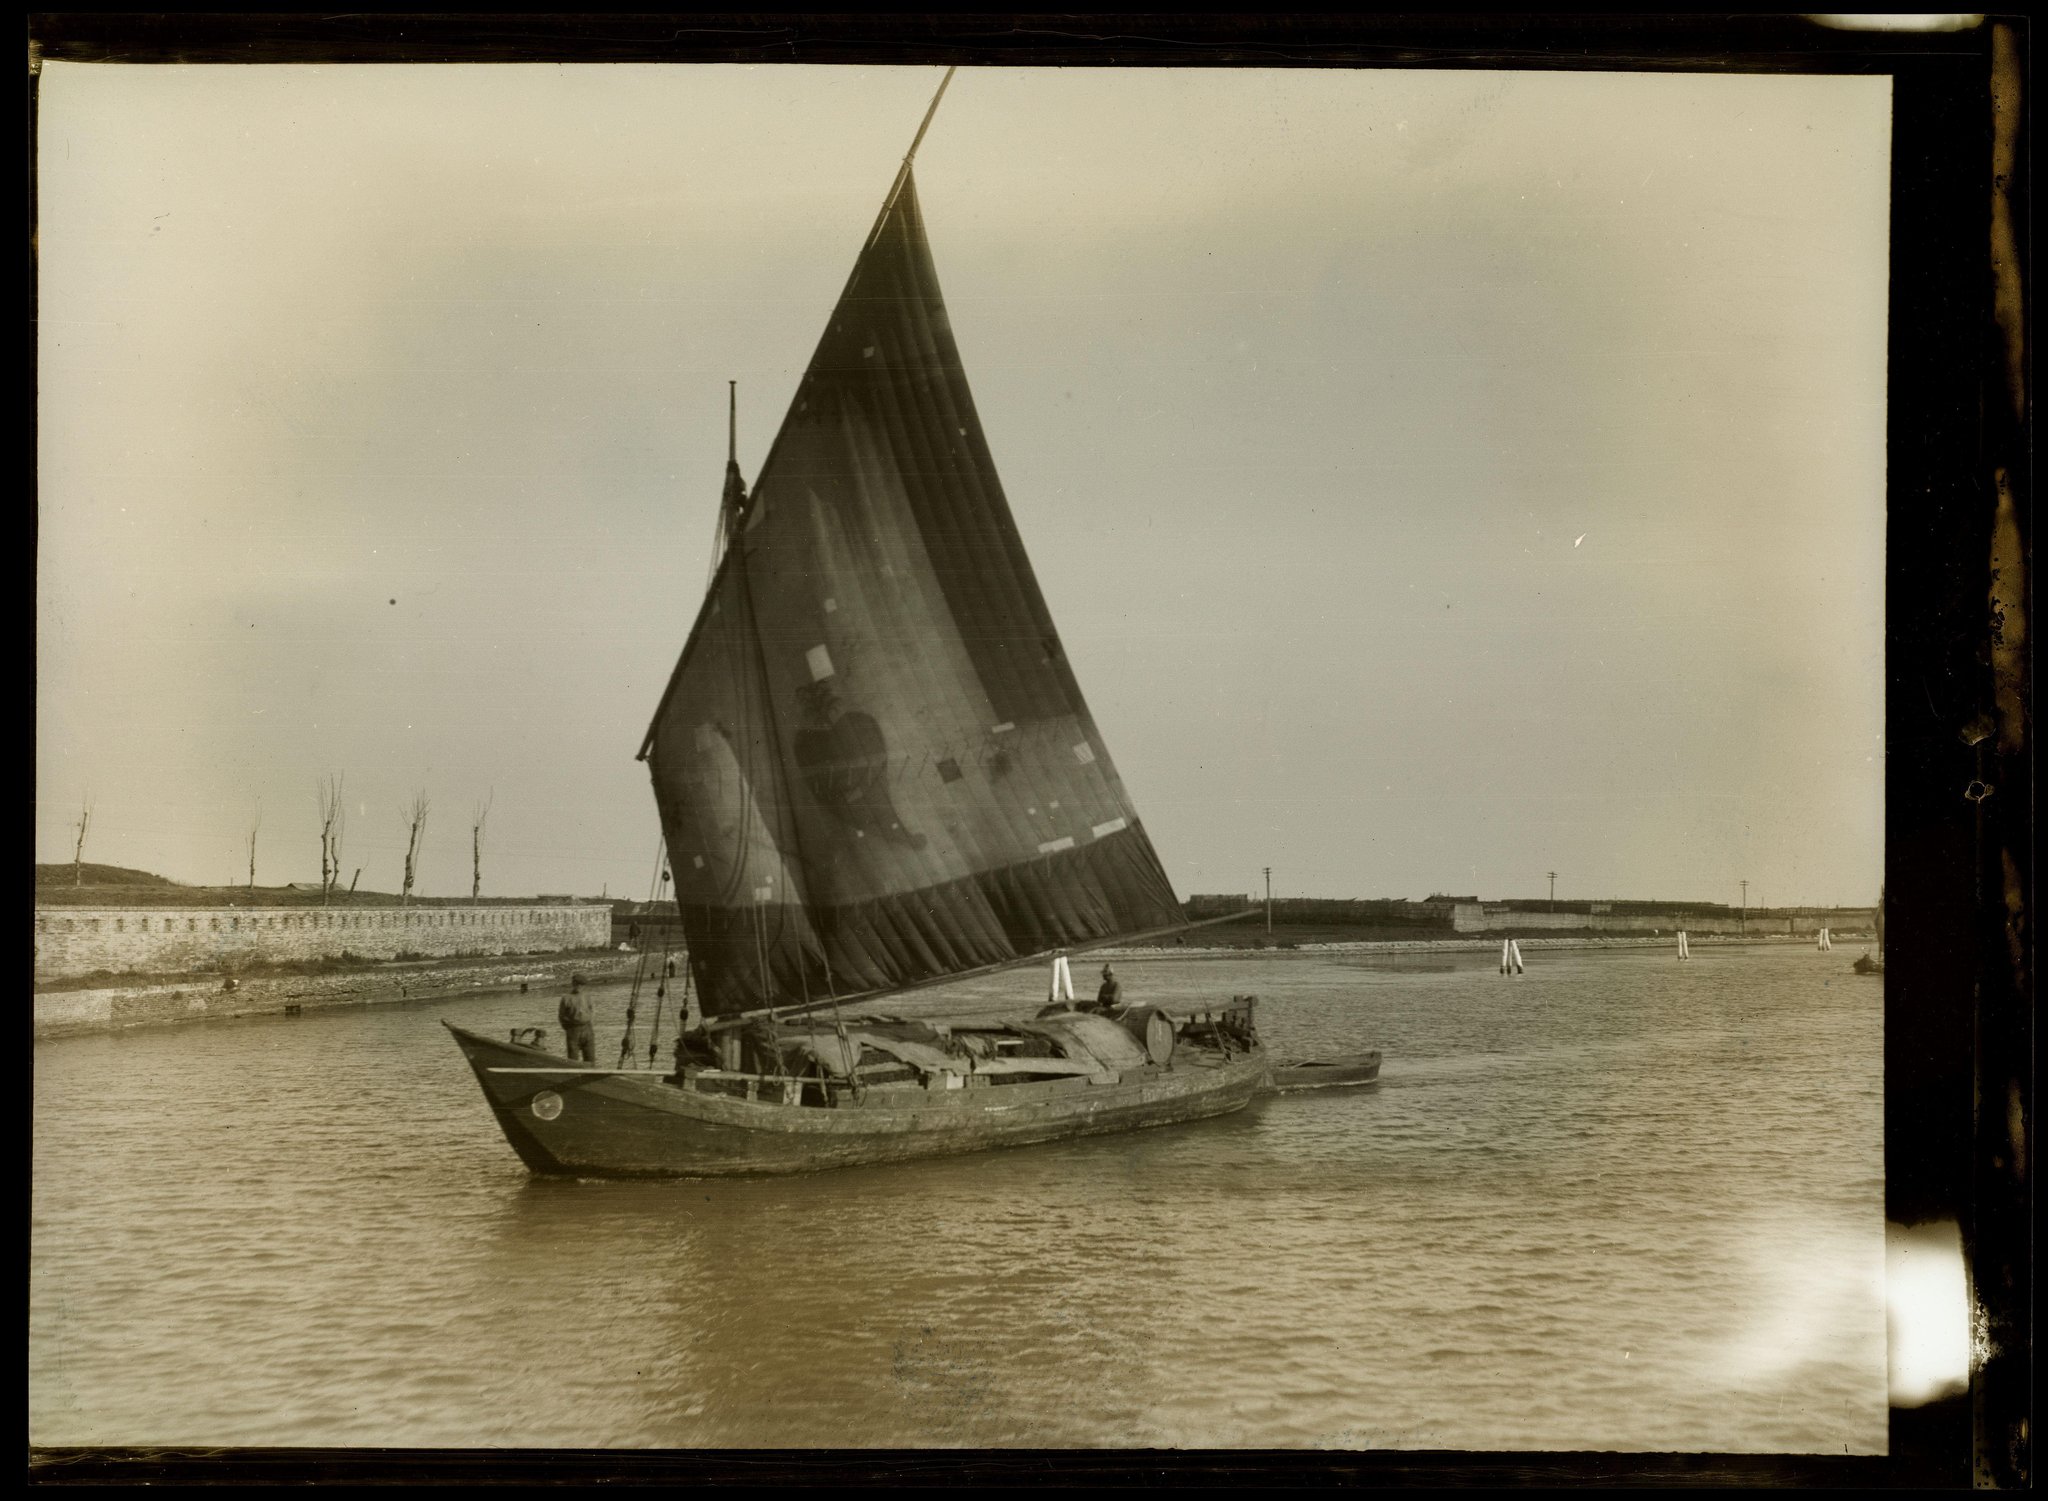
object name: negative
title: Filmnegatief met opname van Venetië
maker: Anonymous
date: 1907-1935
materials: film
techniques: gelatin silver negative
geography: venice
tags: venice